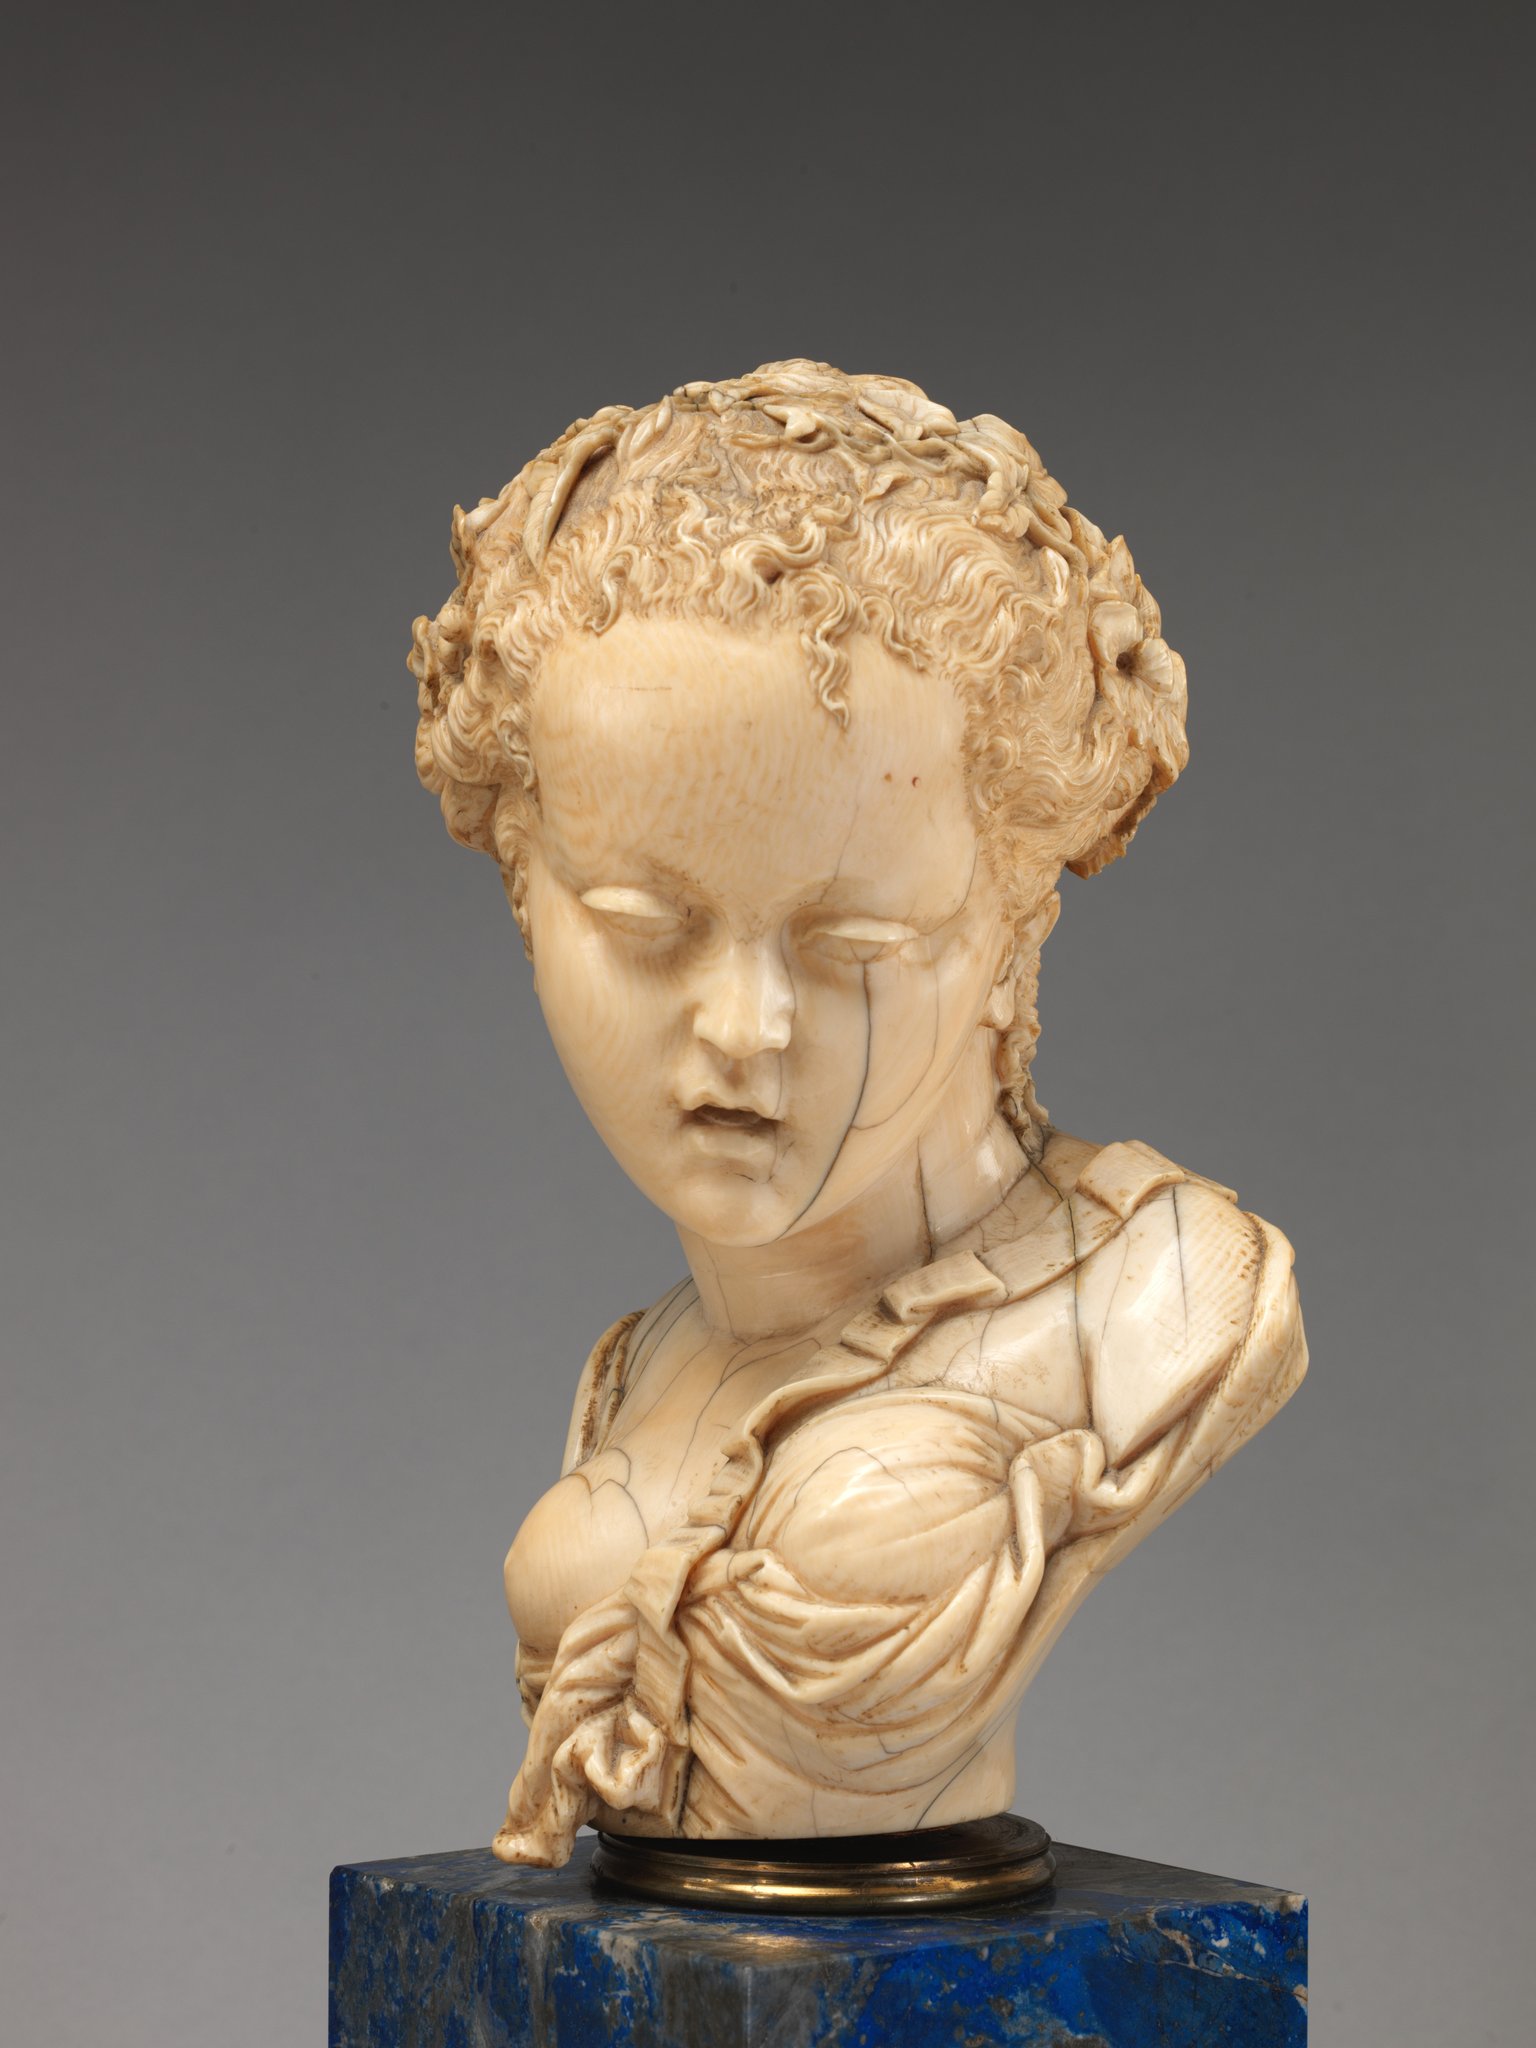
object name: bust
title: Bust of a girl (Flora?)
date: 1840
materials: bronze, ivory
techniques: carving, molding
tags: girls